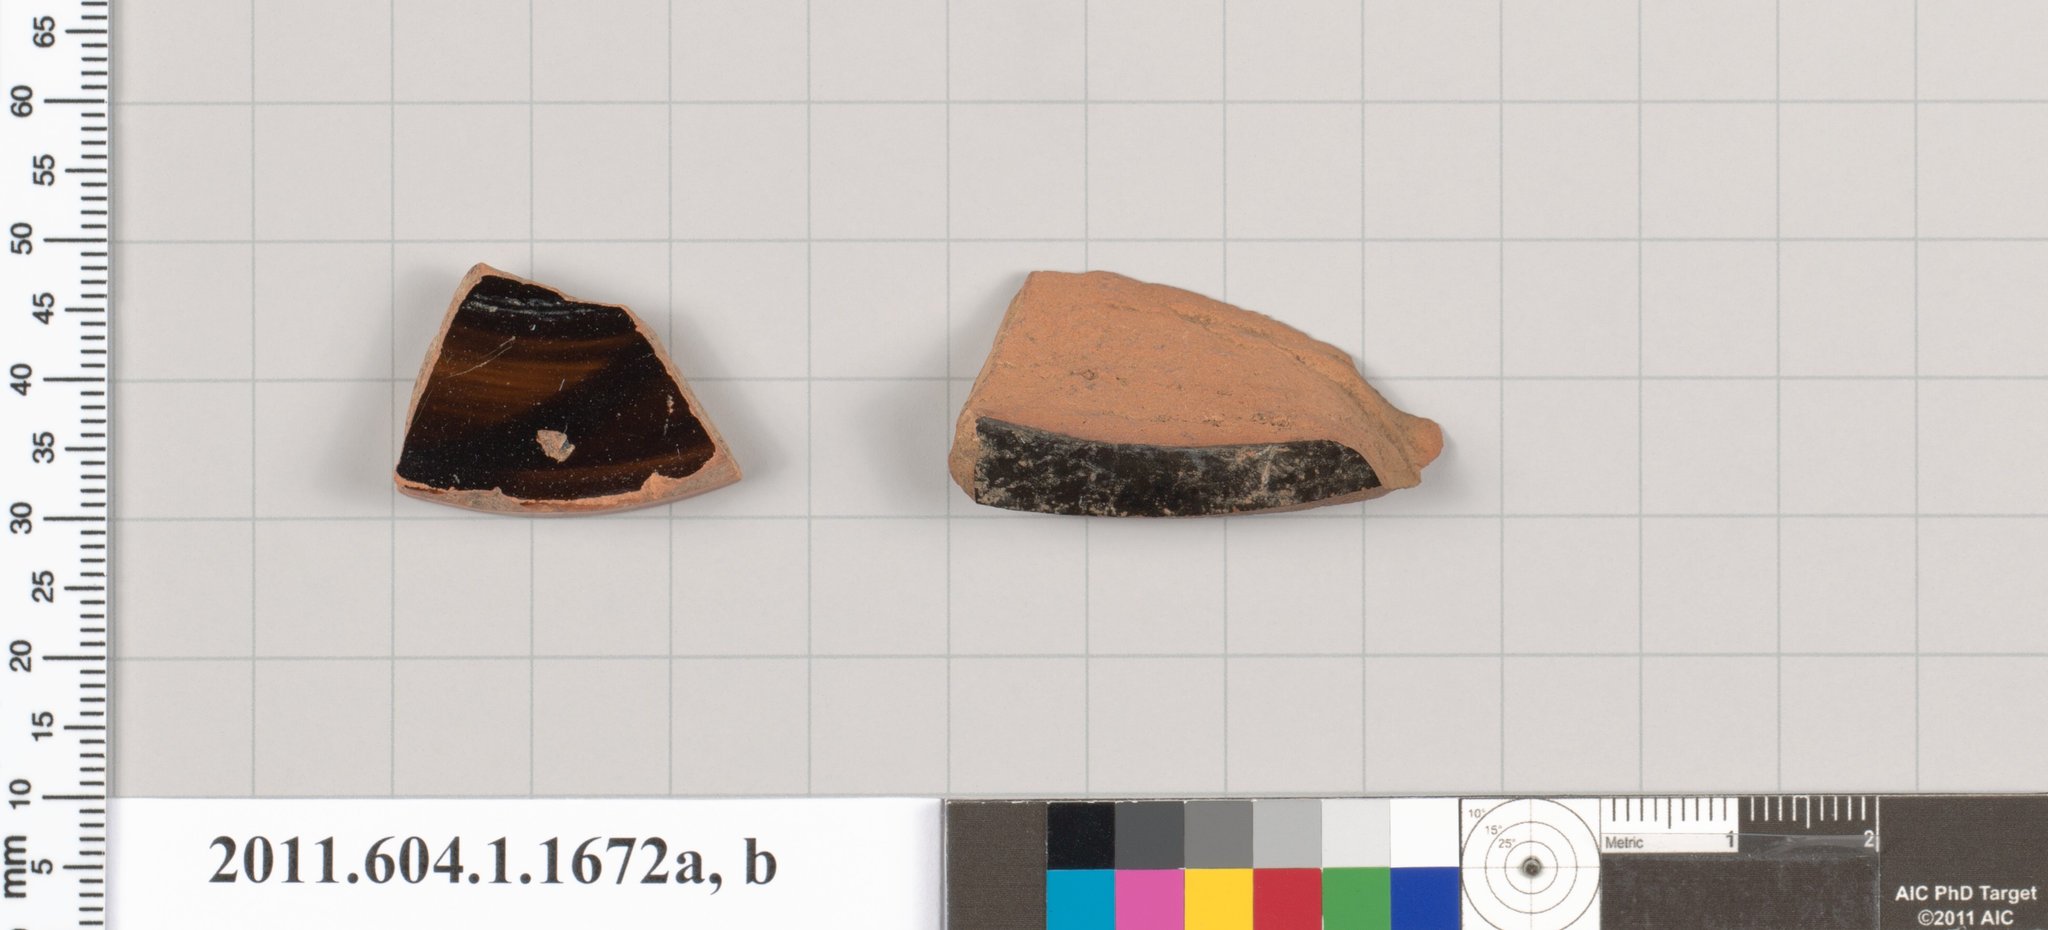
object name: kylix fragment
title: Terracotta fragments of kylikes (drinking cups)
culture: greek, attic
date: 534-468 BCE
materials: terracotta